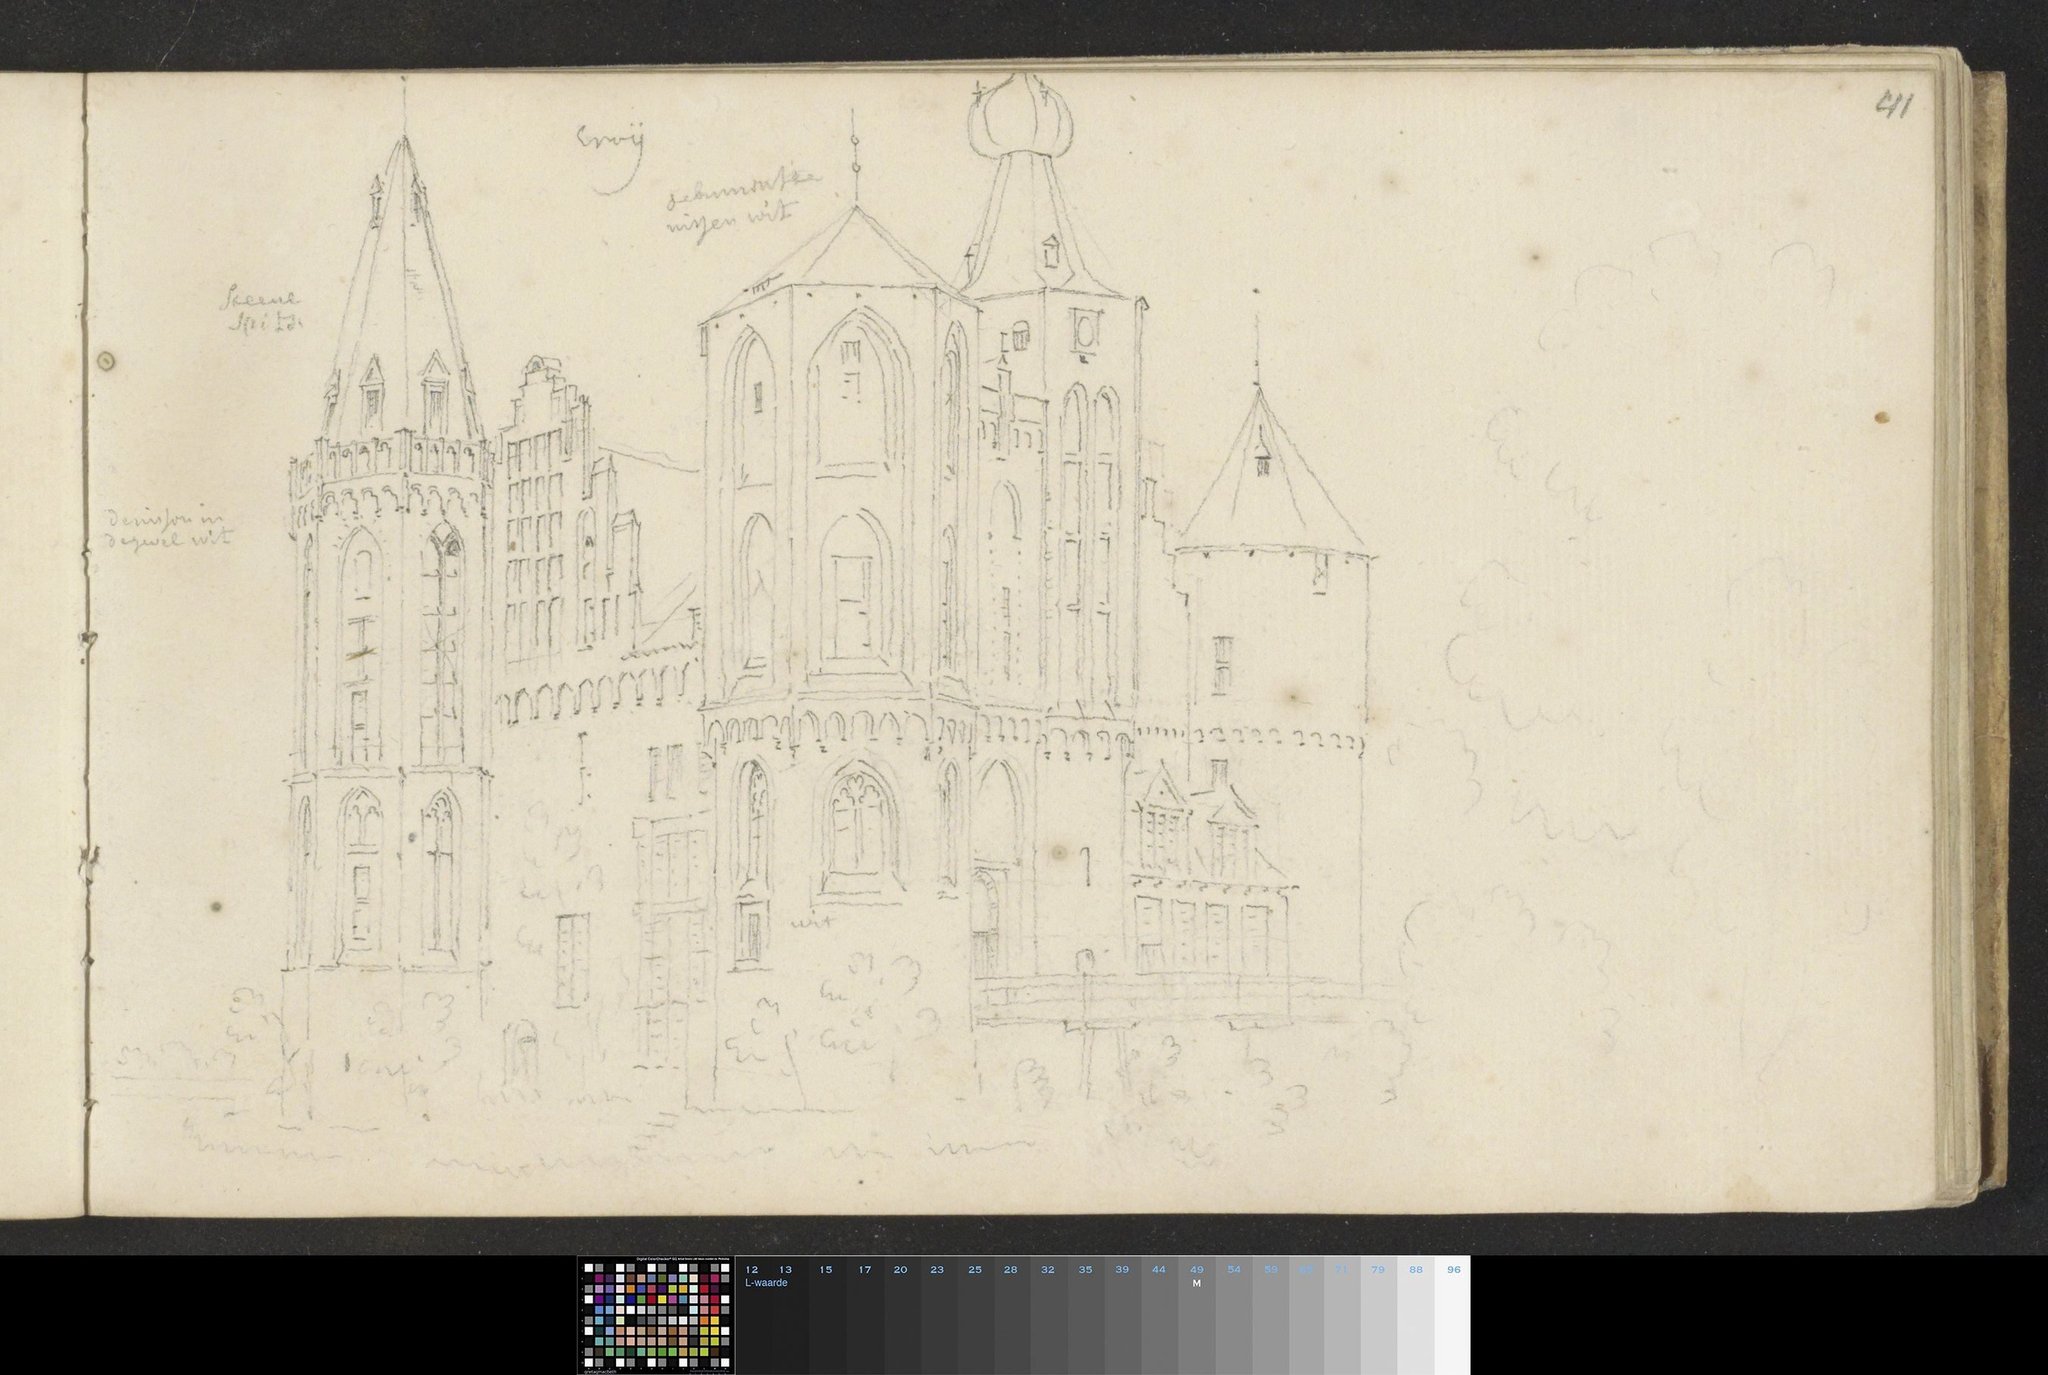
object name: sketchbook leaf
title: Kasteel Croy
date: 1701-1759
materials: paper, pencil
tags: castle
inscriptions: annotation: ‘Croij’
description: Blad 41 recto uit een schetsboek met 65 bladen.